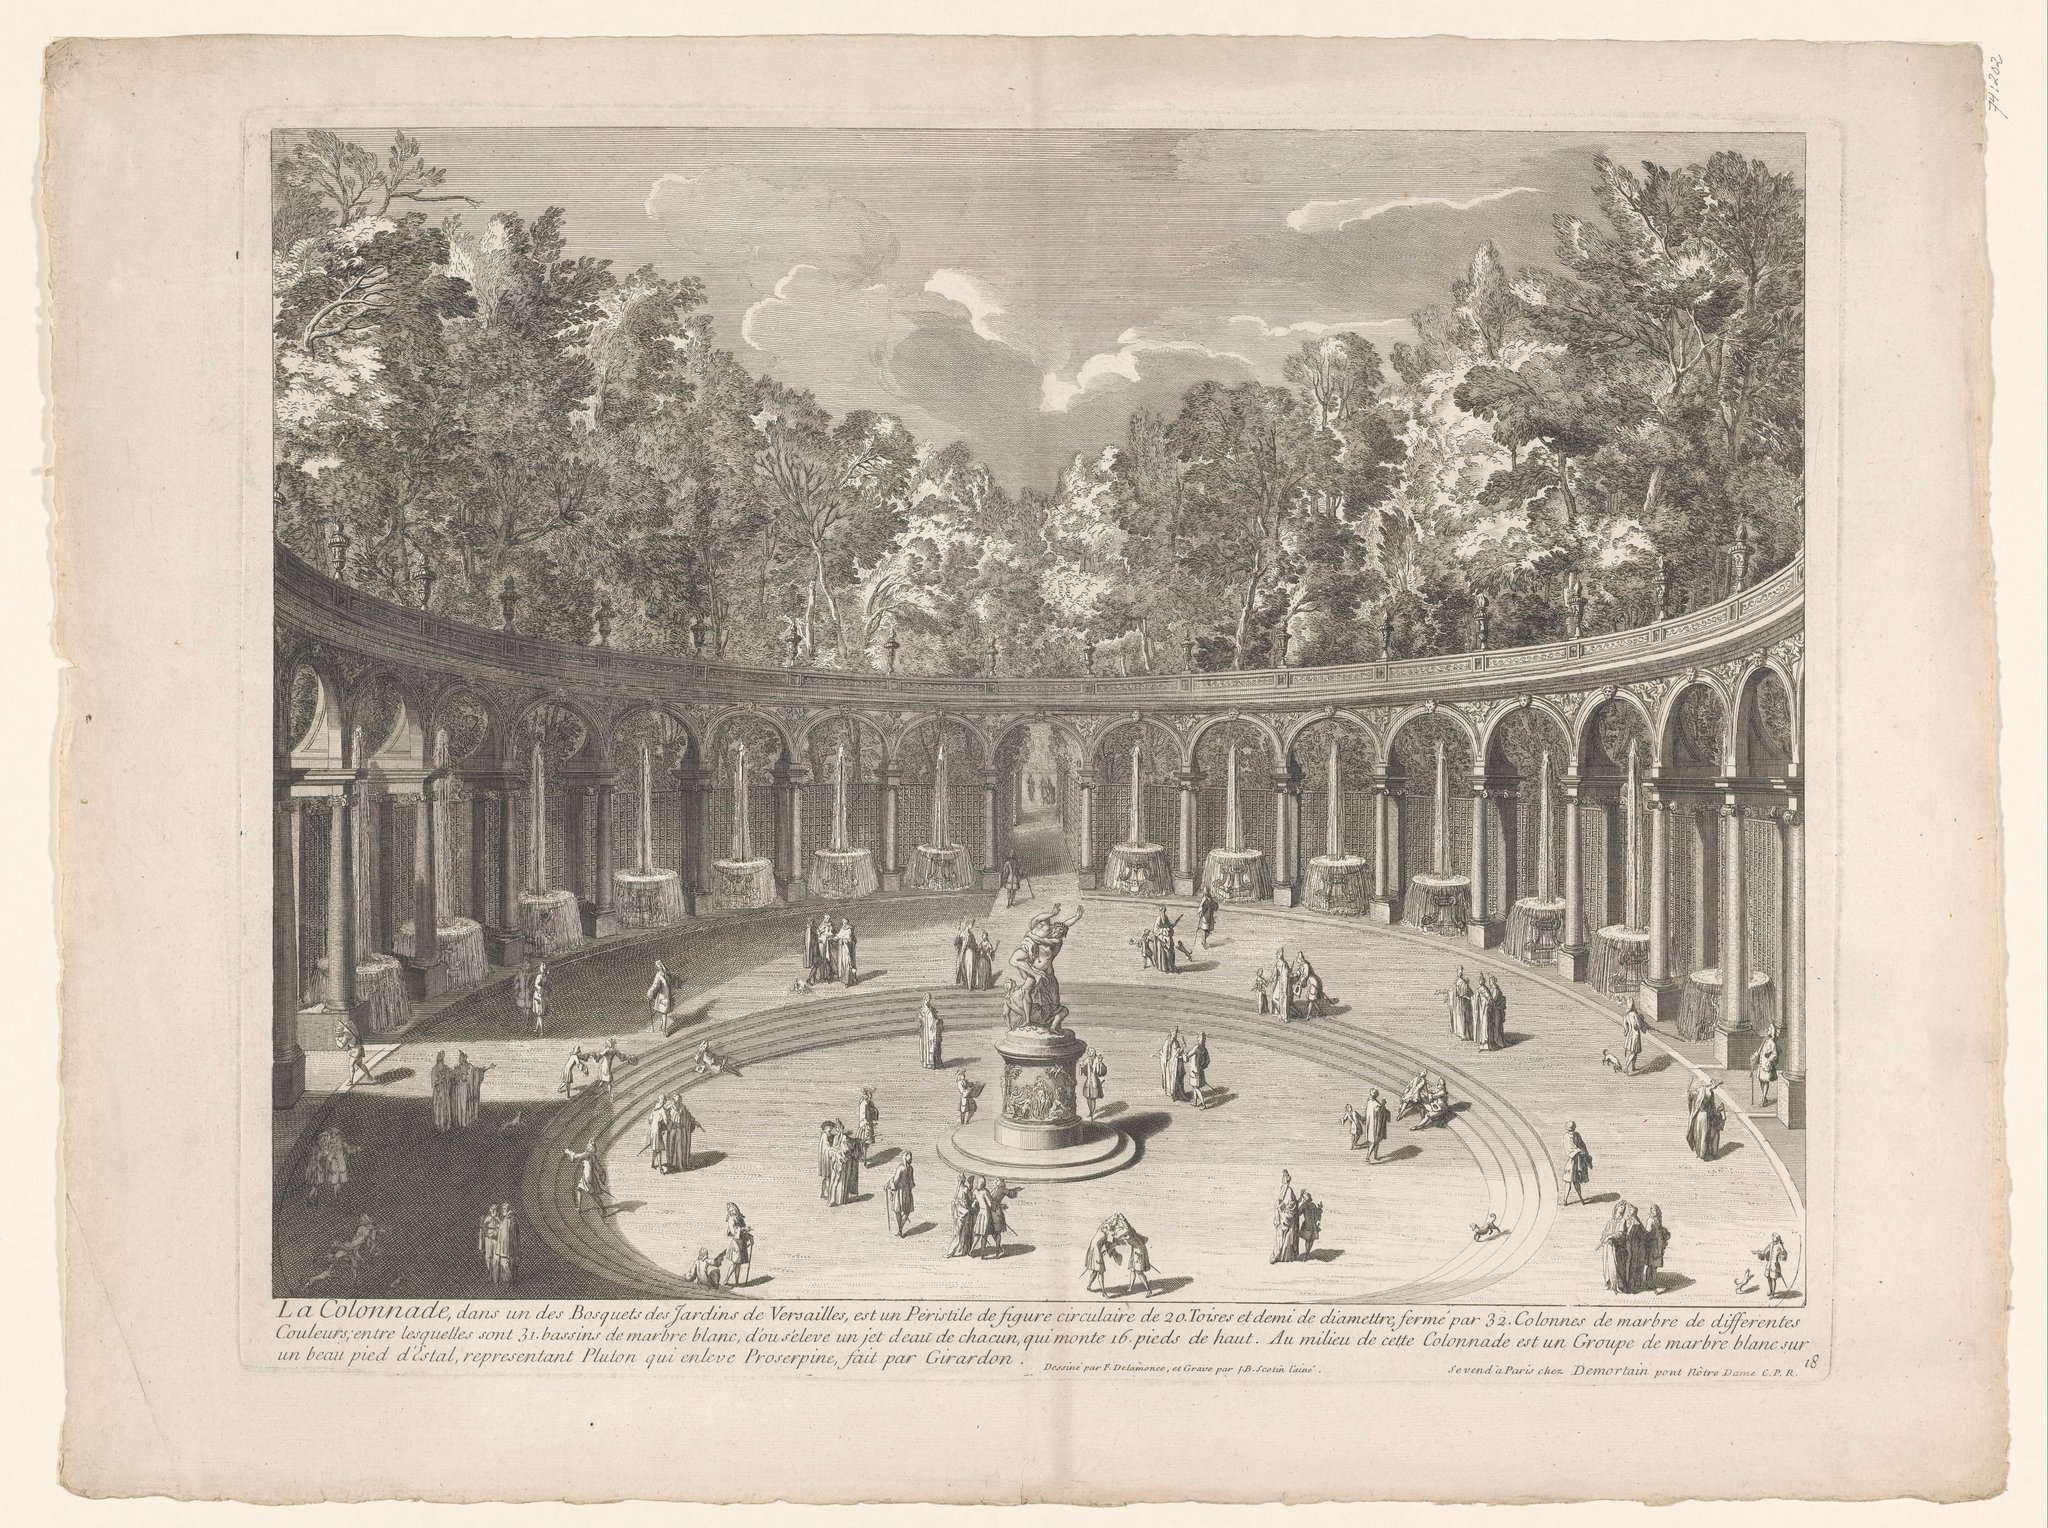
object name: print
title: La colonnade, dans un des bosuets des jardins de Versailles (...)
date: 1715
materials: paper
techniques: engraving, etching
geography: paris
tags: french or architectonic garden; formal garden, statues, sculptures in garden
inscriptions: collector's mark: Lugt 2760, collector's mark: Lugt 2228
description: Prent ook gebruikt in: Les Plans, Profils, Et Elevations, Des Ville, Et Château De Versailles (...). Parijs: Gilles de Demortain, [1715].